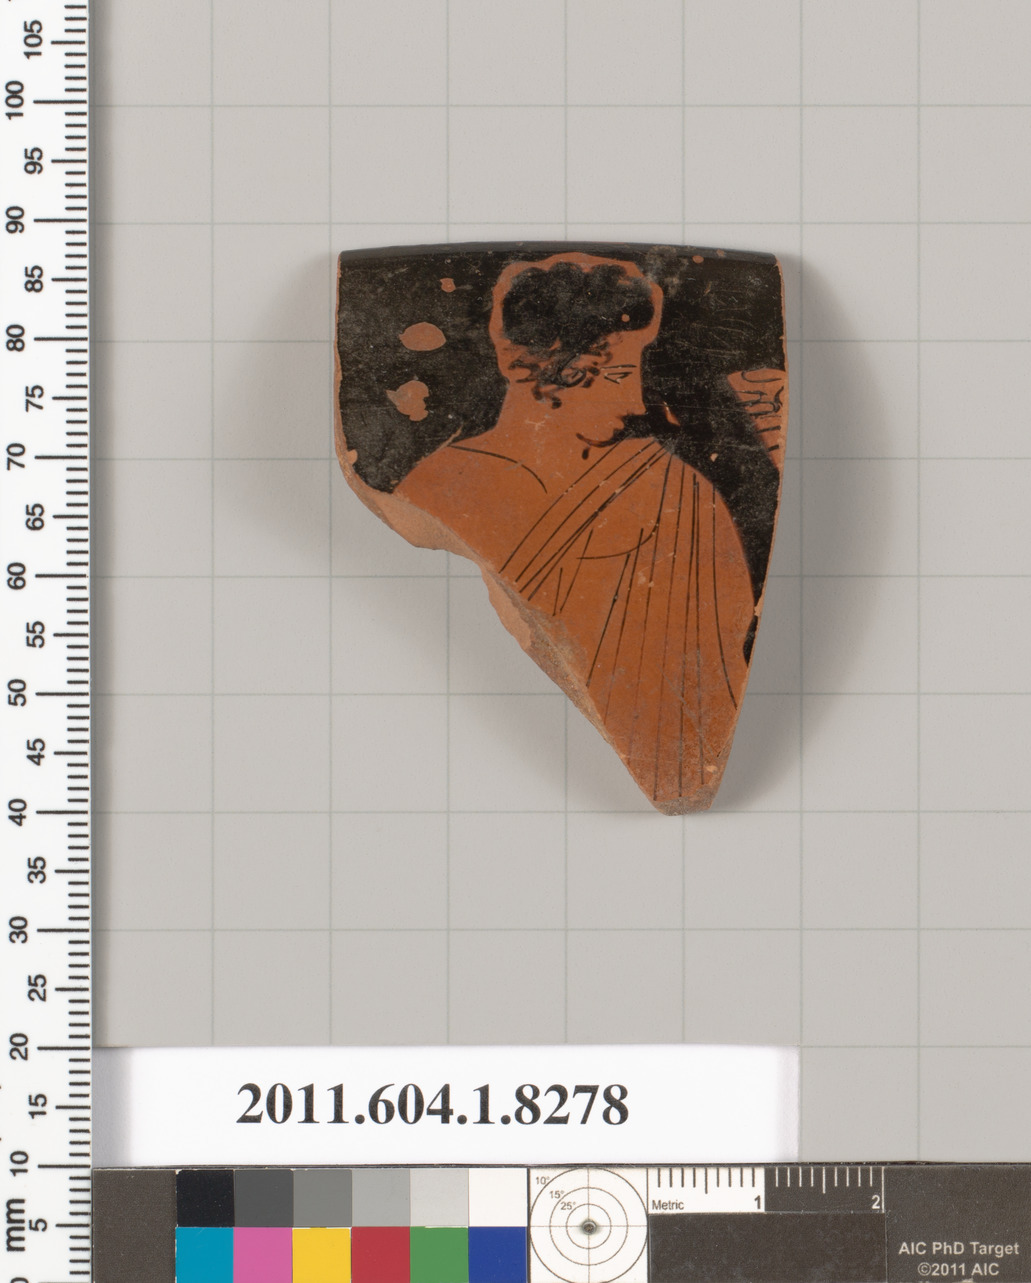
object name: kylix fragment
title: Terracotta rim fragment of a kylix (drinking cup)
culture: greek, attic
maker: montlaurès painter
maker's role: artist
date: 400-368 BCE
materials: terracotta